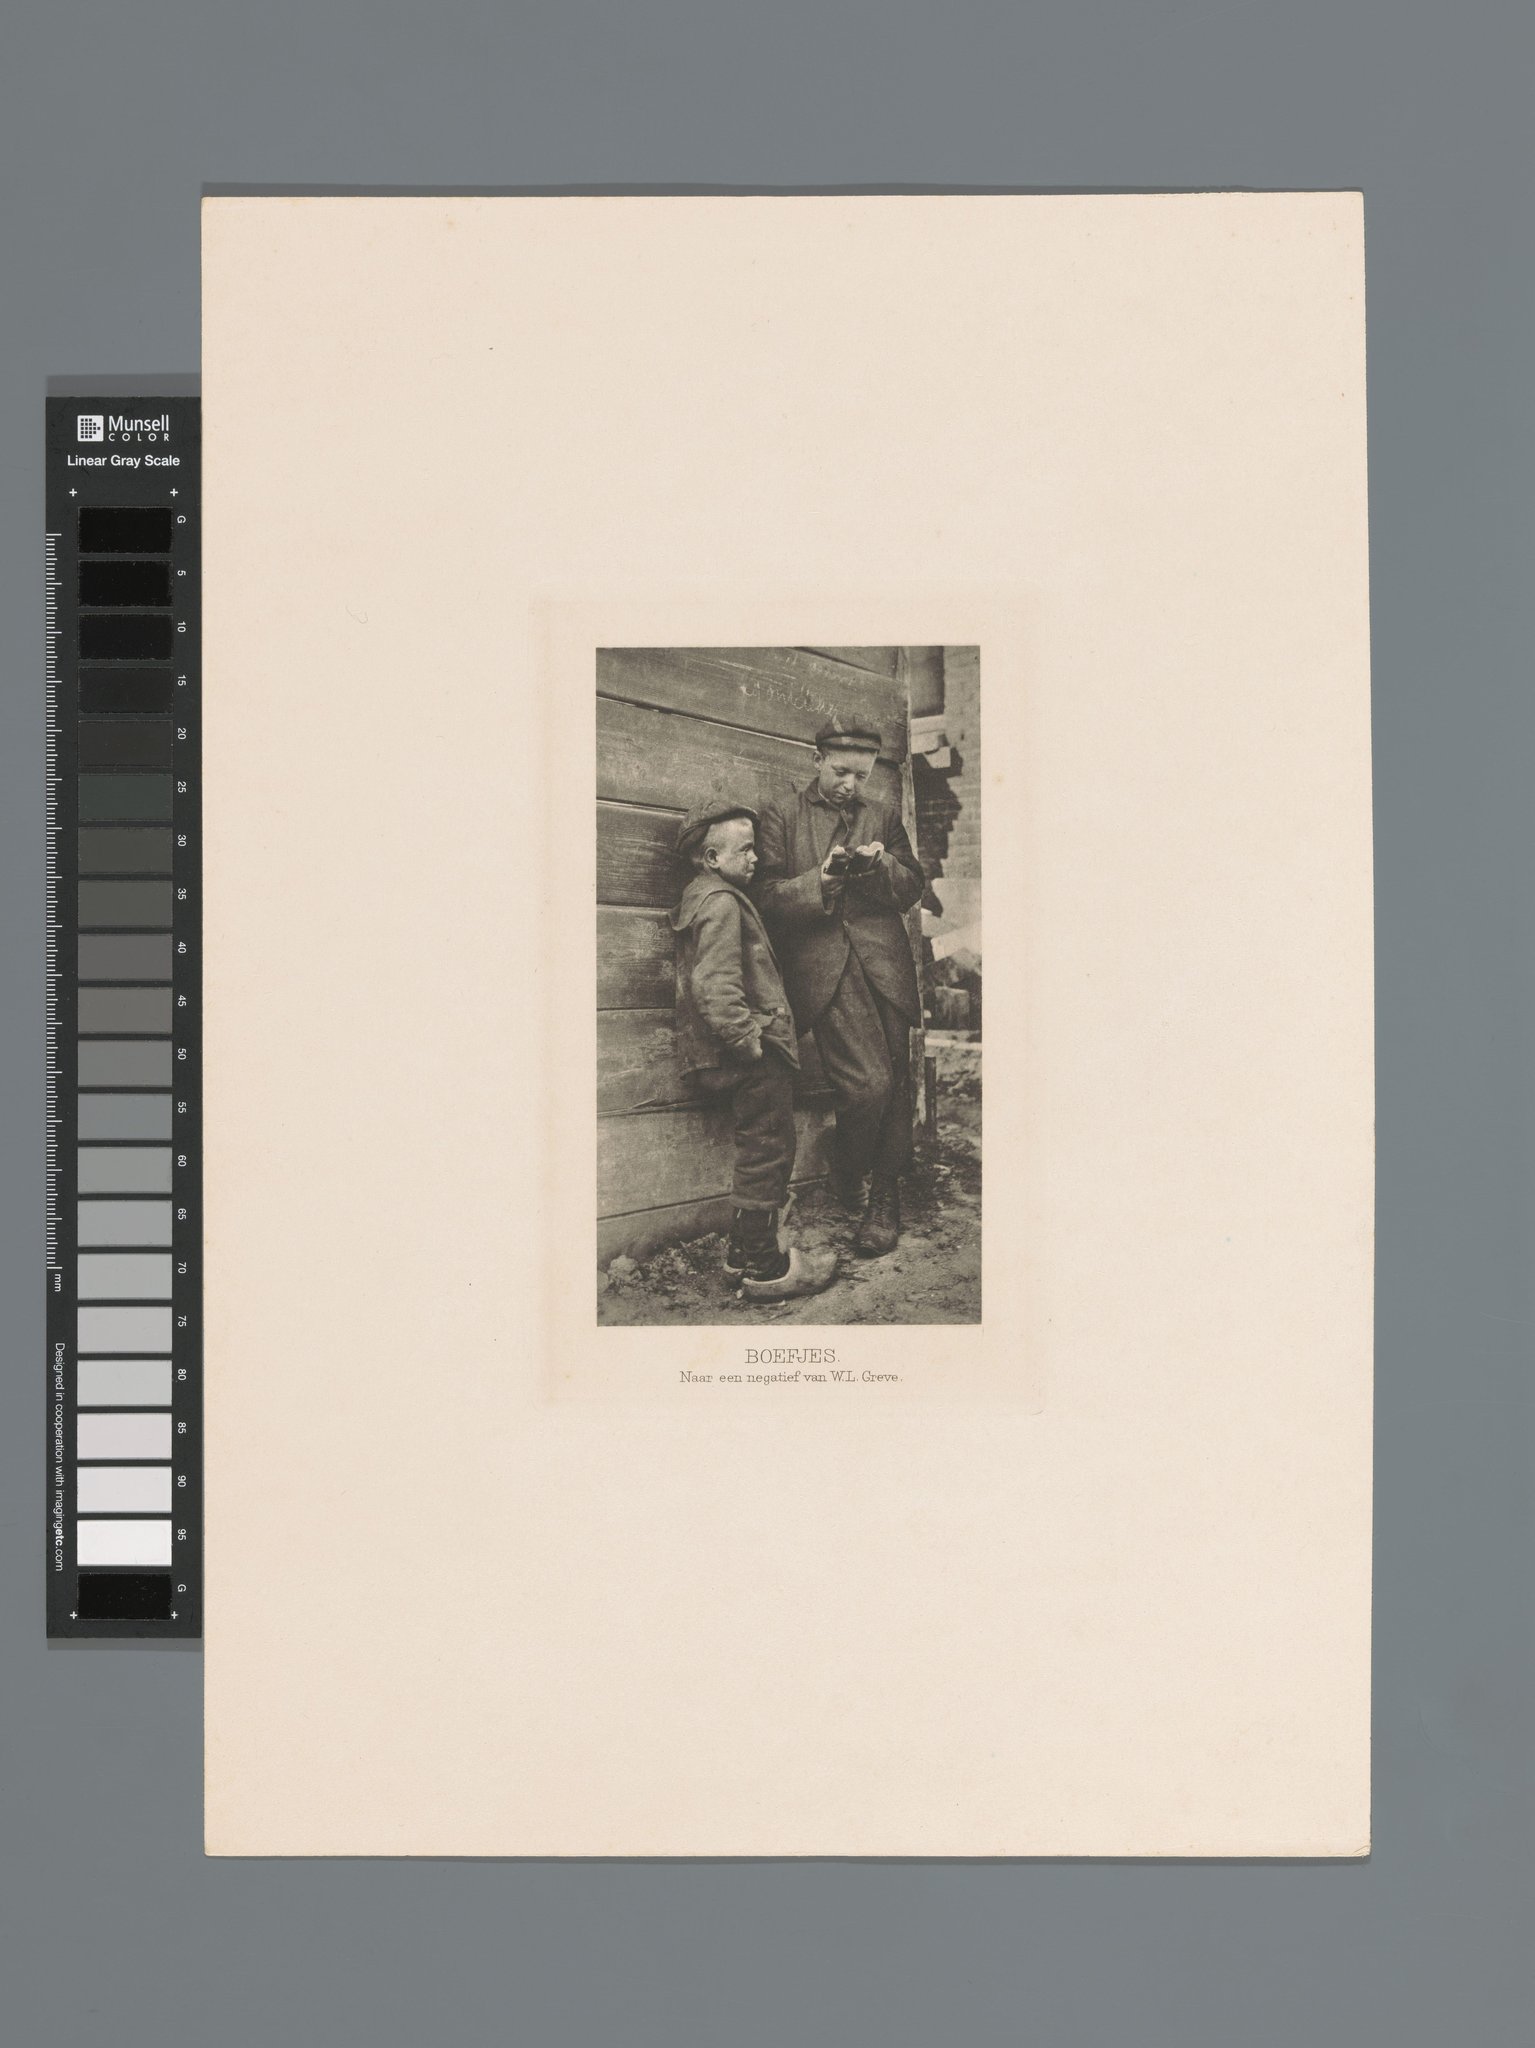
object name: photomechanical print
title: Boefjes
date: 1901-1906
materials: paper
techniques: photoaquatint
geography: netherlands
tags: boy (child between toddler and youth), child